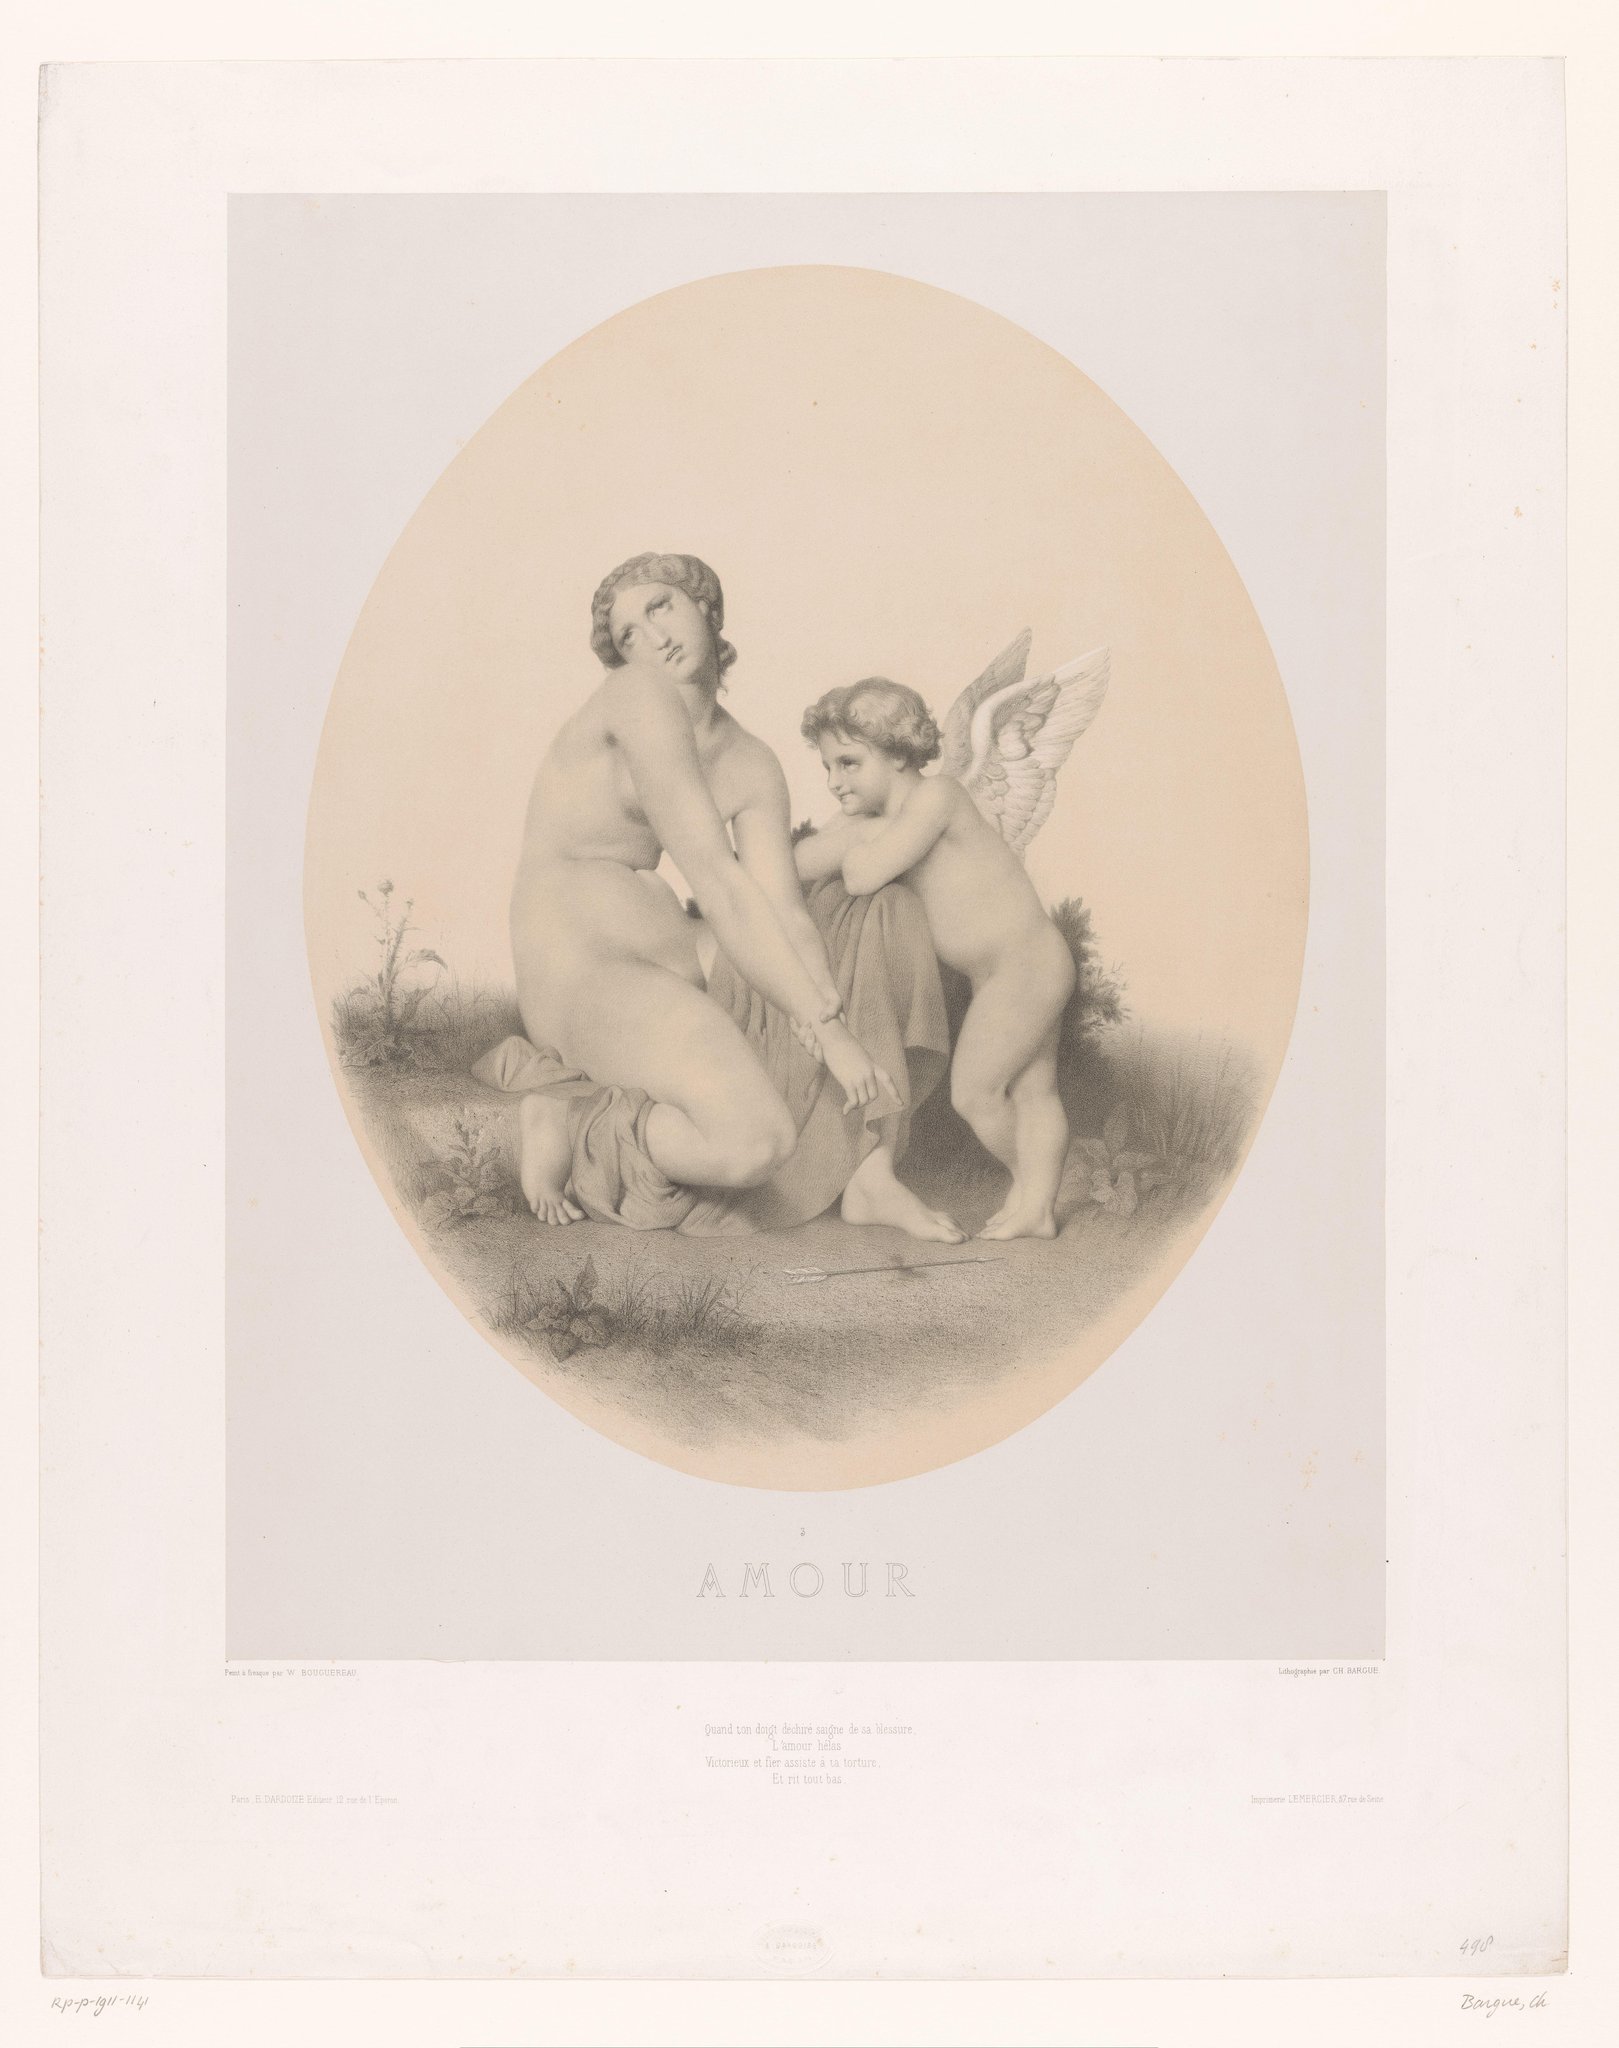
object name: print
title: Huis in de natuur met op de achtergrond bergen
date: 1837-1843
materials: paper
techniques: tone lithography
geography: paris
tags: rural housing, e.g. country-house, villa, cottage, mountains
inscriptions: collector's mark: Lugt 2228